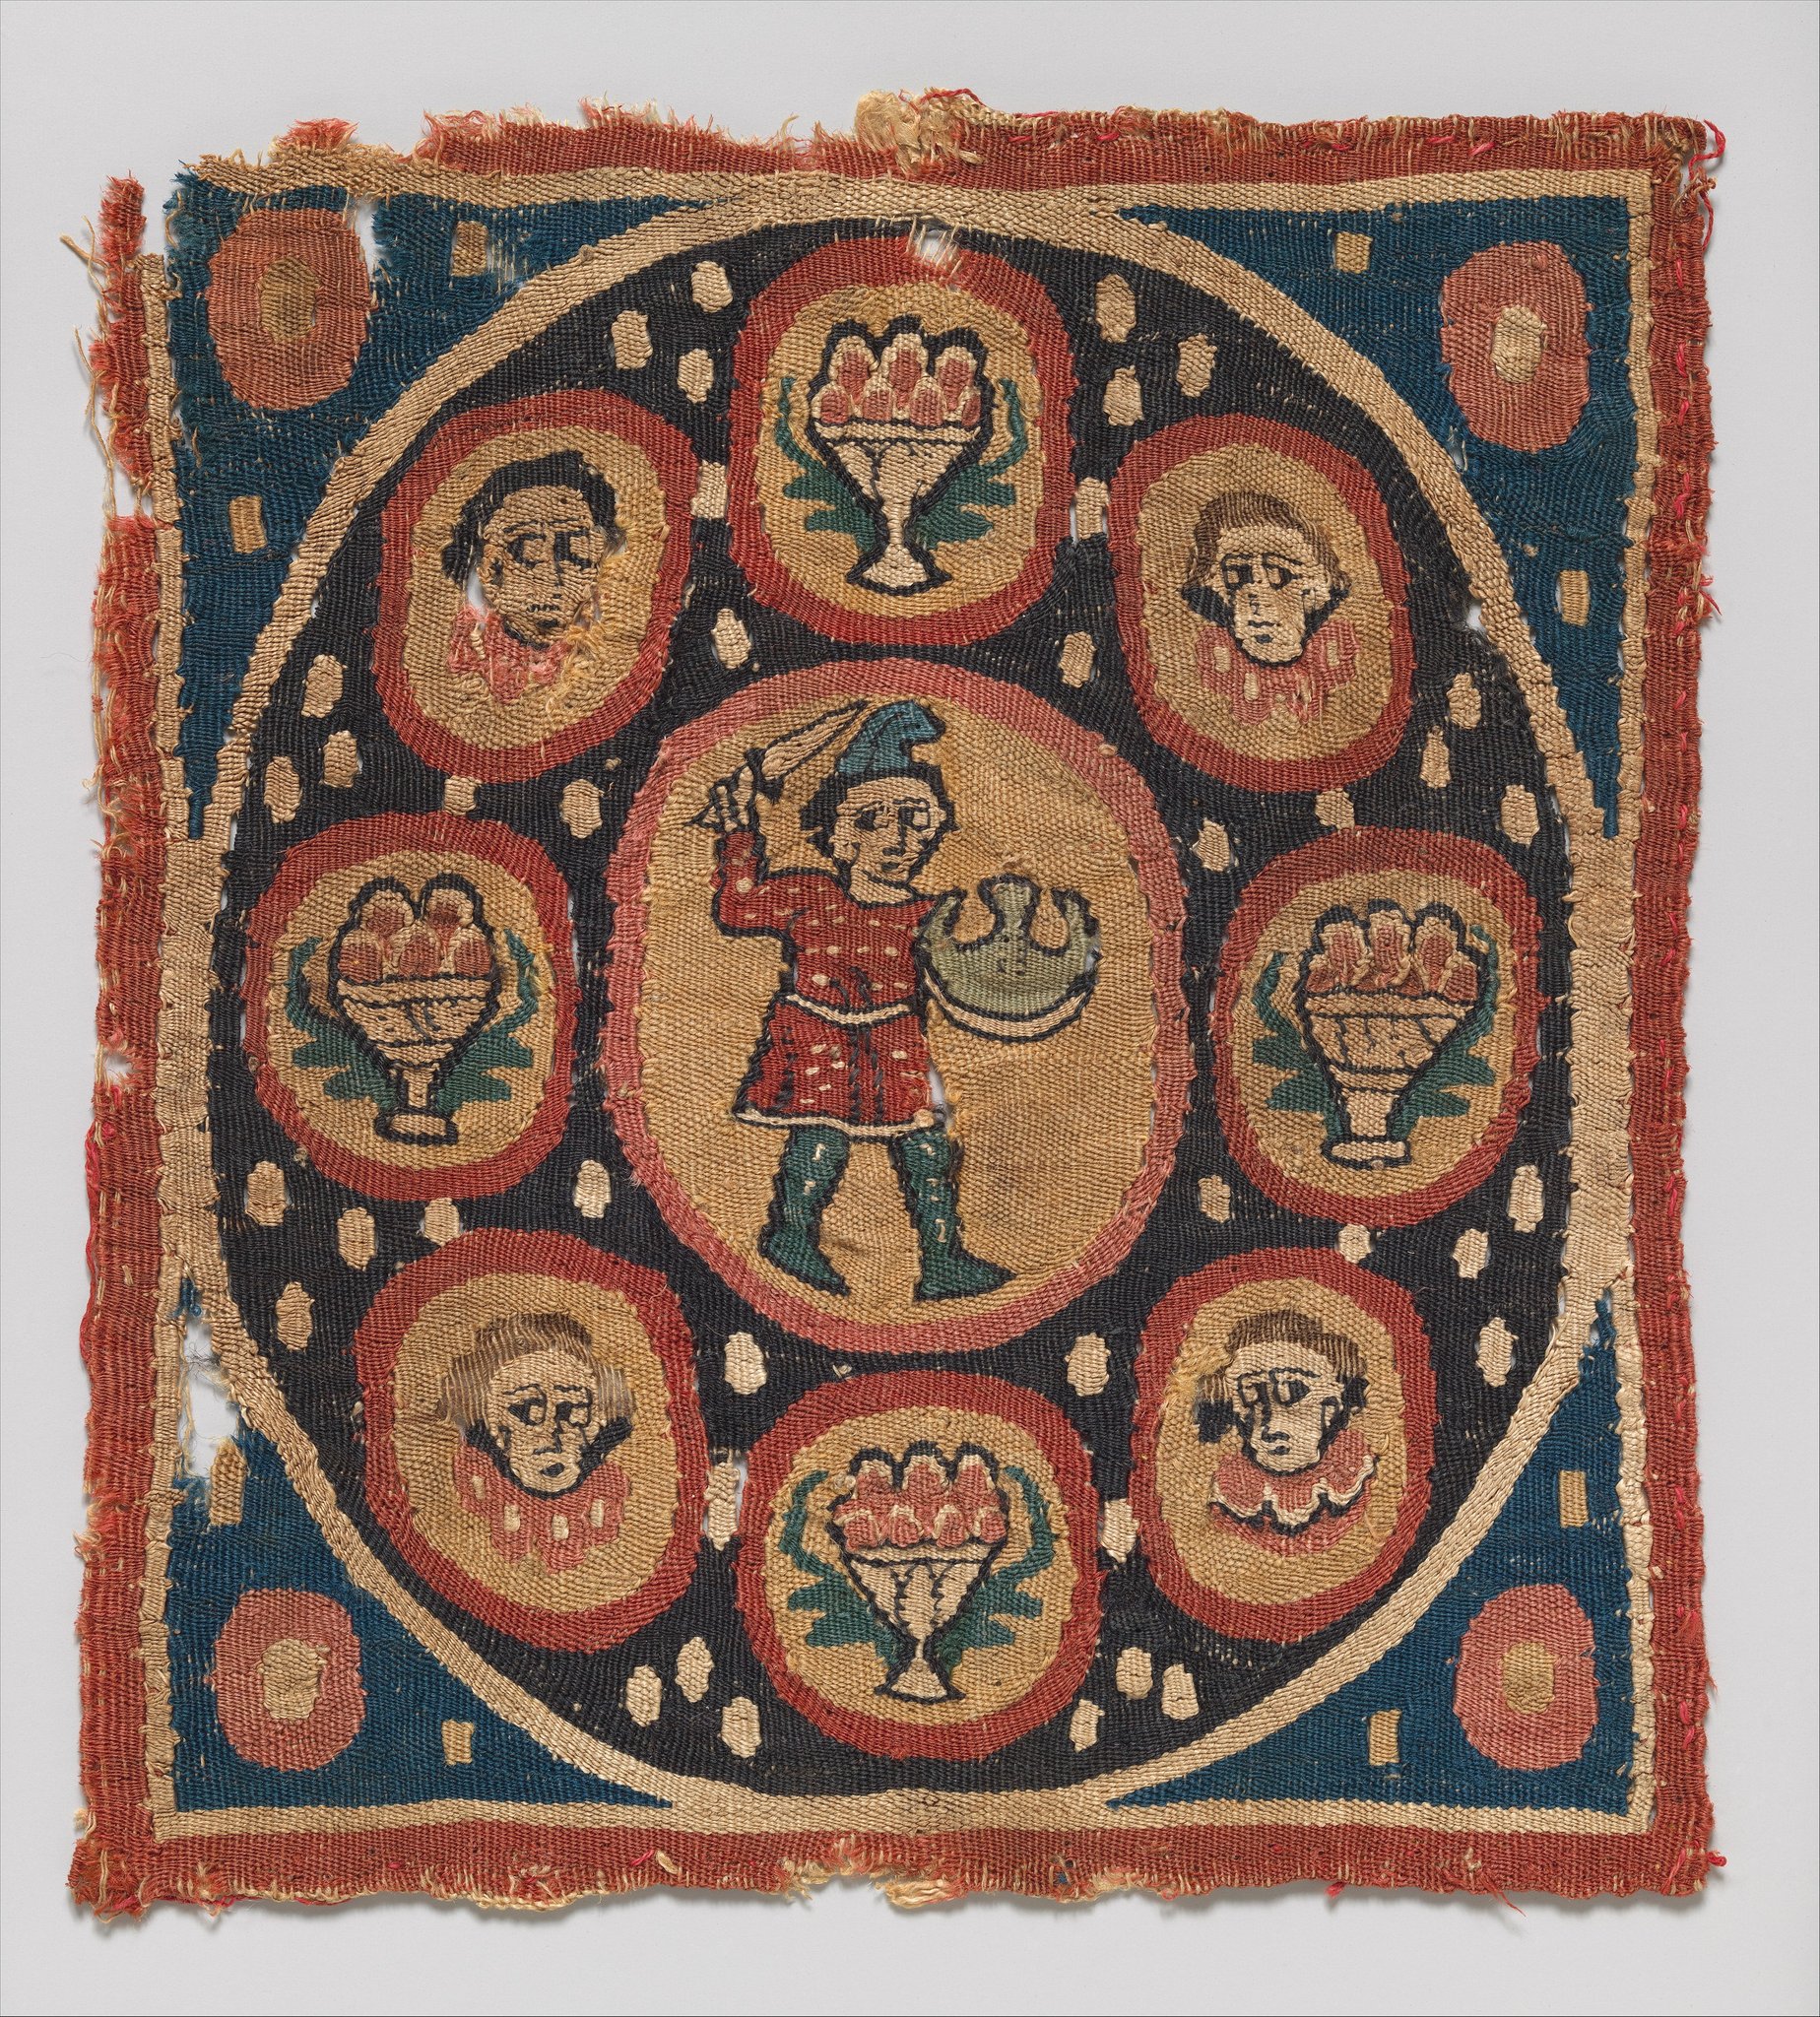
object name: textile fragment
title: Square with Warrior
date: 401-600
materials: linen, wool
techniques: weave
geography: egypt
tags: shields,swords,warriors